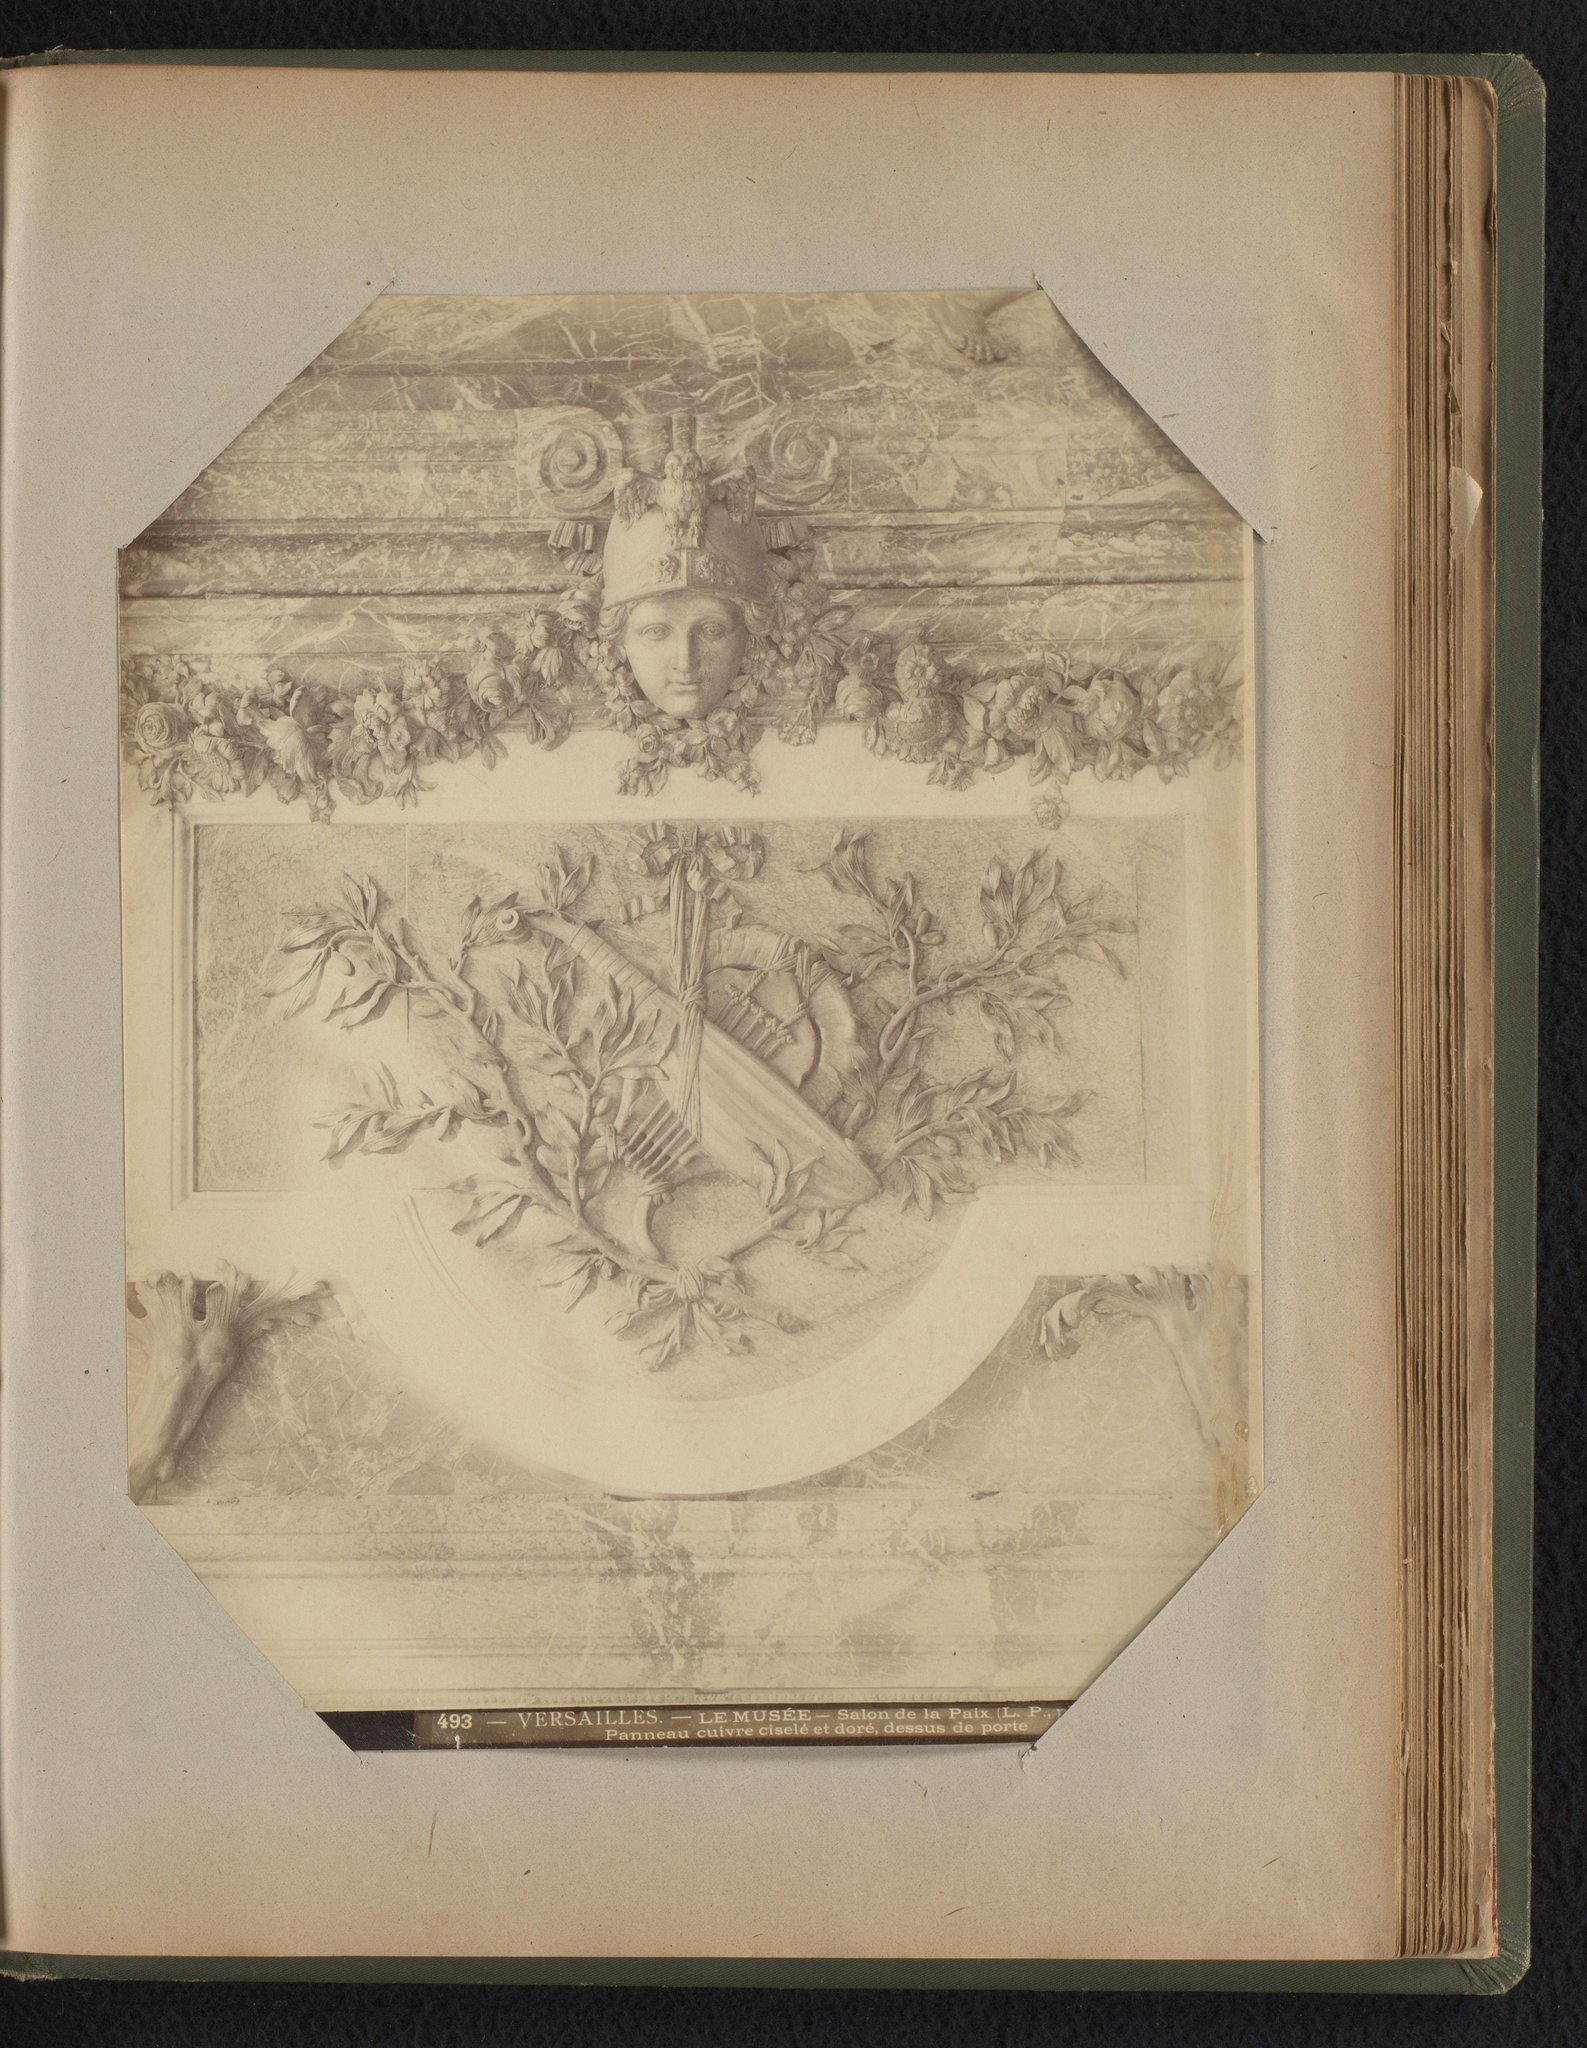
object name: photograph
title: 493 - Versailles Le Musee - Salon de paix (L.P. Phot). Panneau cuivre cisele et doré, dessus de porte.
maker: Anonymous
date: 1860-1900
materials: paper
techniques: albumen print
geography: france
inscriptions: annotation: ‘493 - Versailles Le Musee - Salon de paix (L.P. Phot). Panneau cuivre cisele et doré, dessus de porte.’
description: Onderdeel van een serie met betrekking tot het interieur van het paleis van Versailles met kroonluchters, deuren, portalen en meubelstukken.